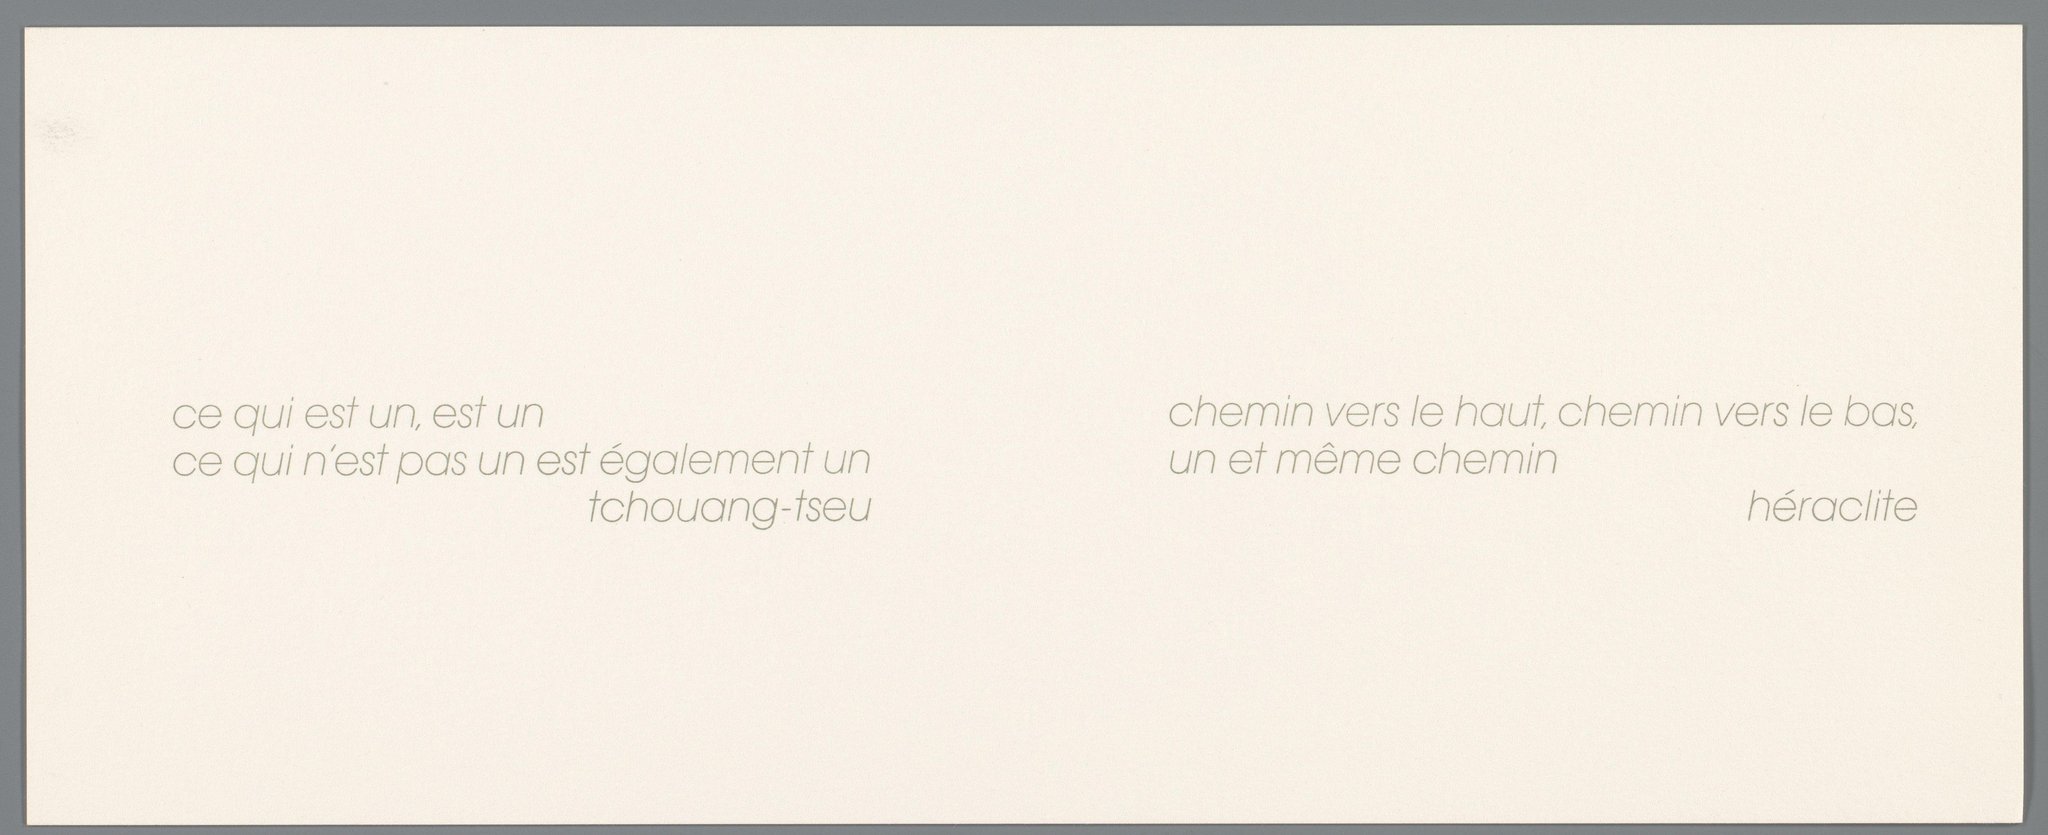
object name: poem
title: Ce qui est un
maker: heraclitus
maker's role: filosoof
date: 1984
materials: paper, ink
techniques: letterpress printing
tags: heraclitus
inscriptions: poem: ‘ce qui est un (...) et meme chemin/ héraclite’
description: Gedicht van de Griekse filosoof Héraclite, in het Frans.